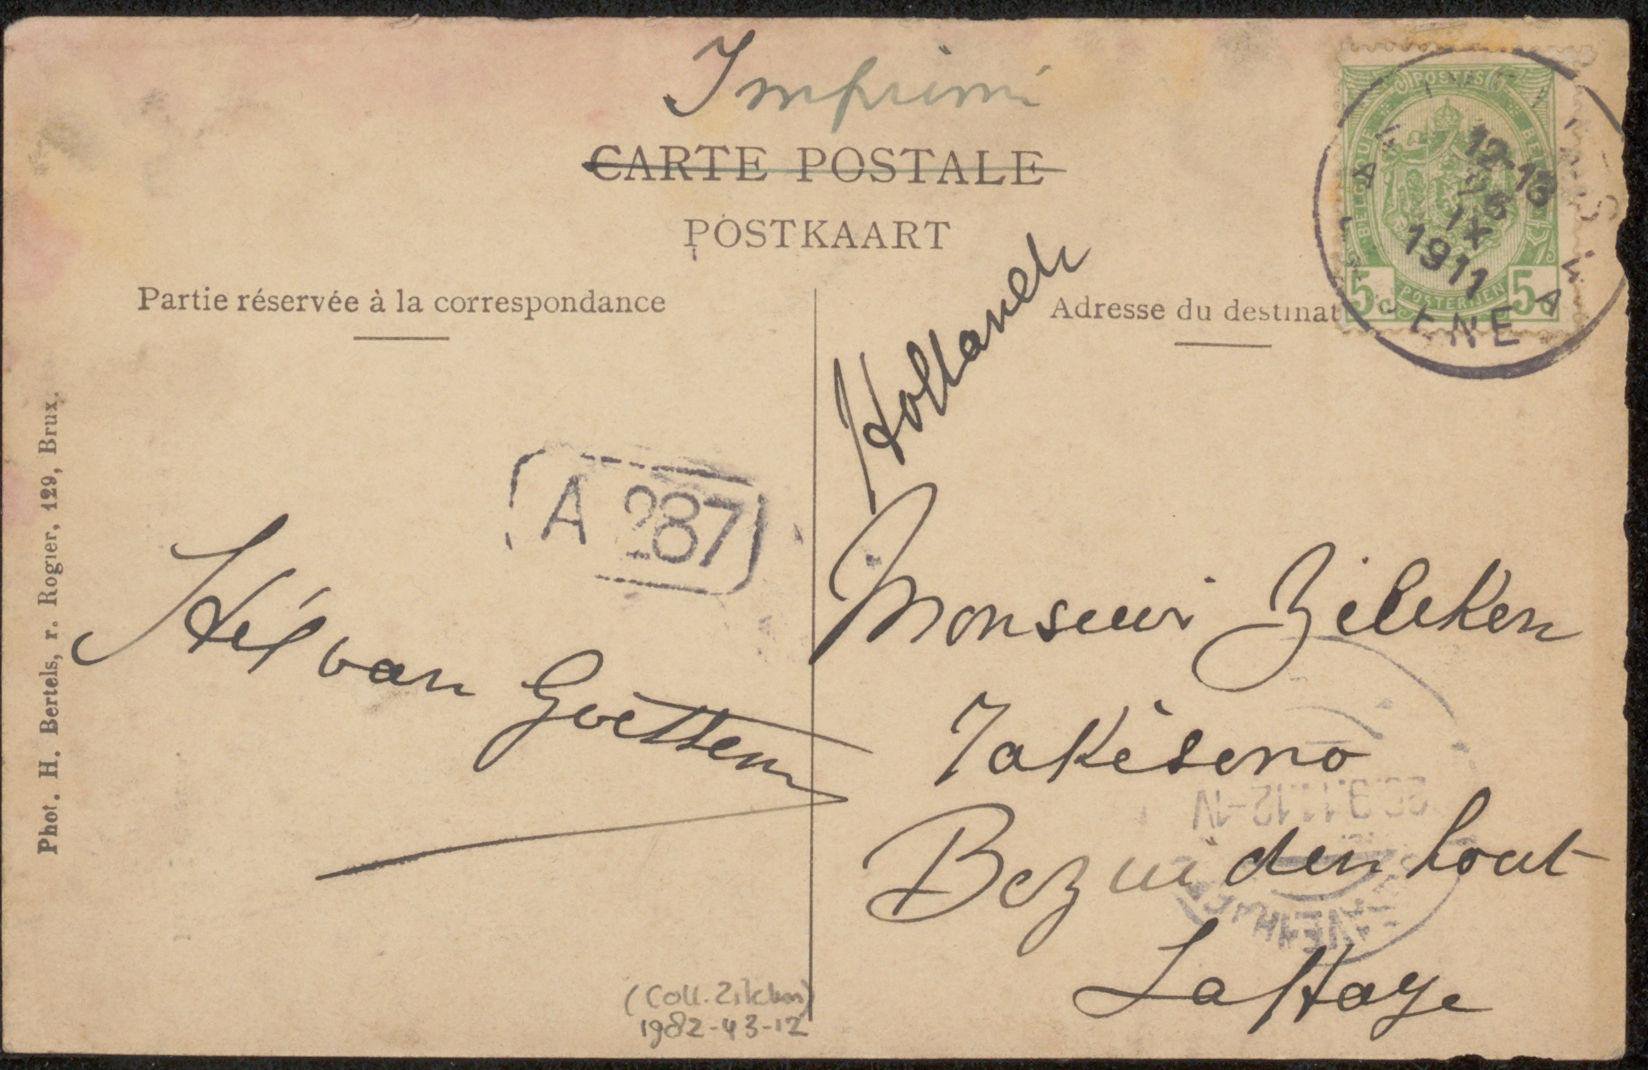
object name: ansichtkaart, prentbriefkaart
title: Prentbriefkaart aan Philip Zilcken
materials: cardboard, ink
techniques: photograph, pen, writing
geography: brussels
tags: draughtsman, philip zilcken